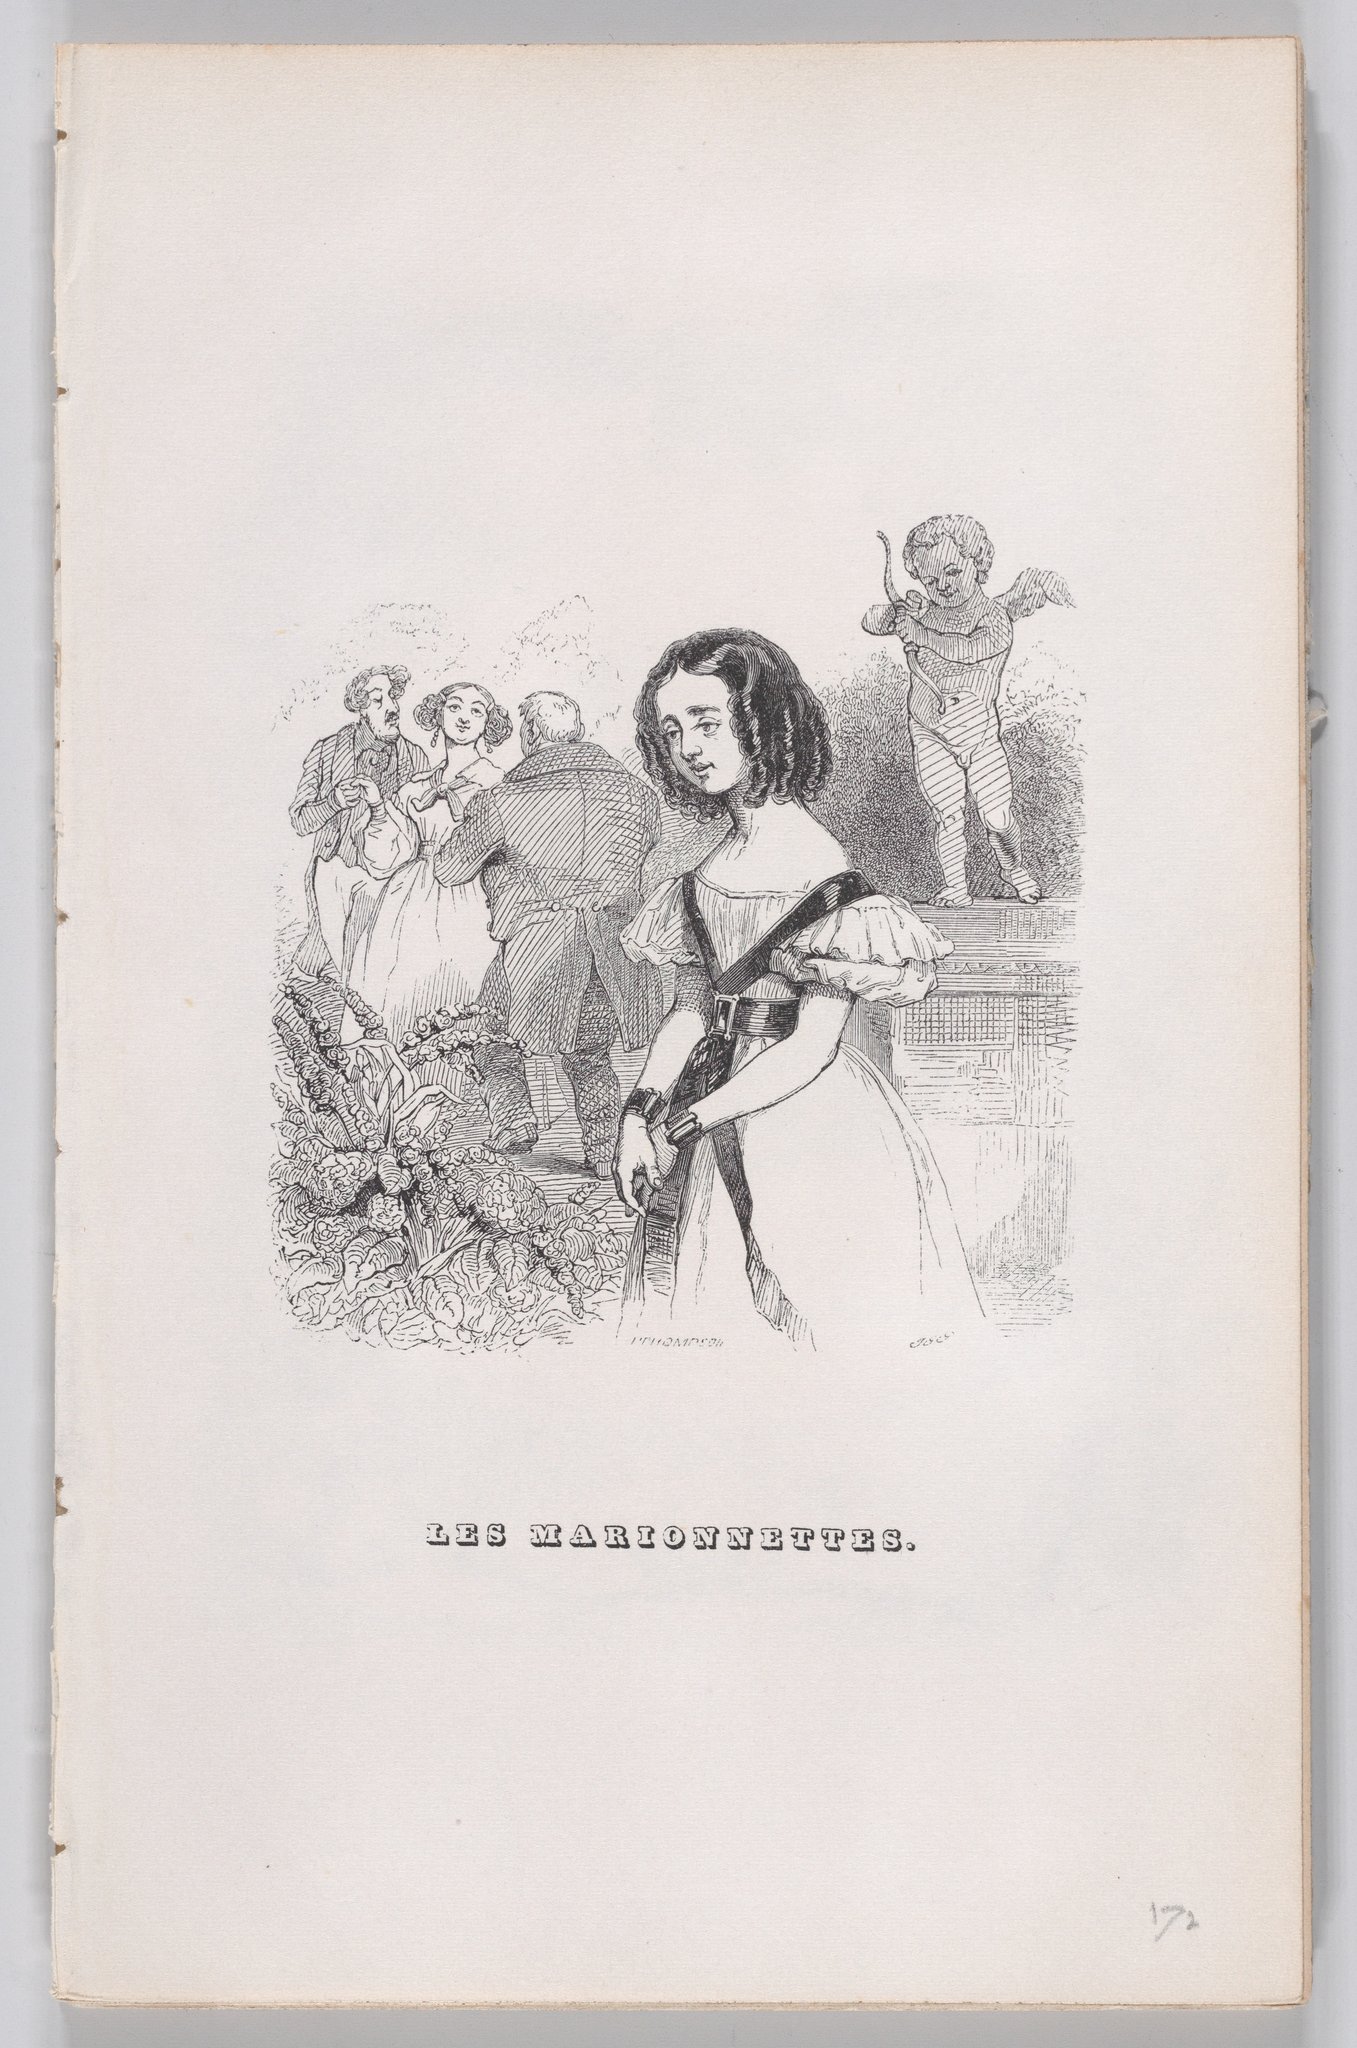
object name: print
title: The Puppets, from "The Complete Works of Béranger"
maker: j. j. grandville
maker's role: illustrator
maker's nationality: french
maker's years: 1803-1847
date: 1836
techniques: engraving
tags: men,women,cupid